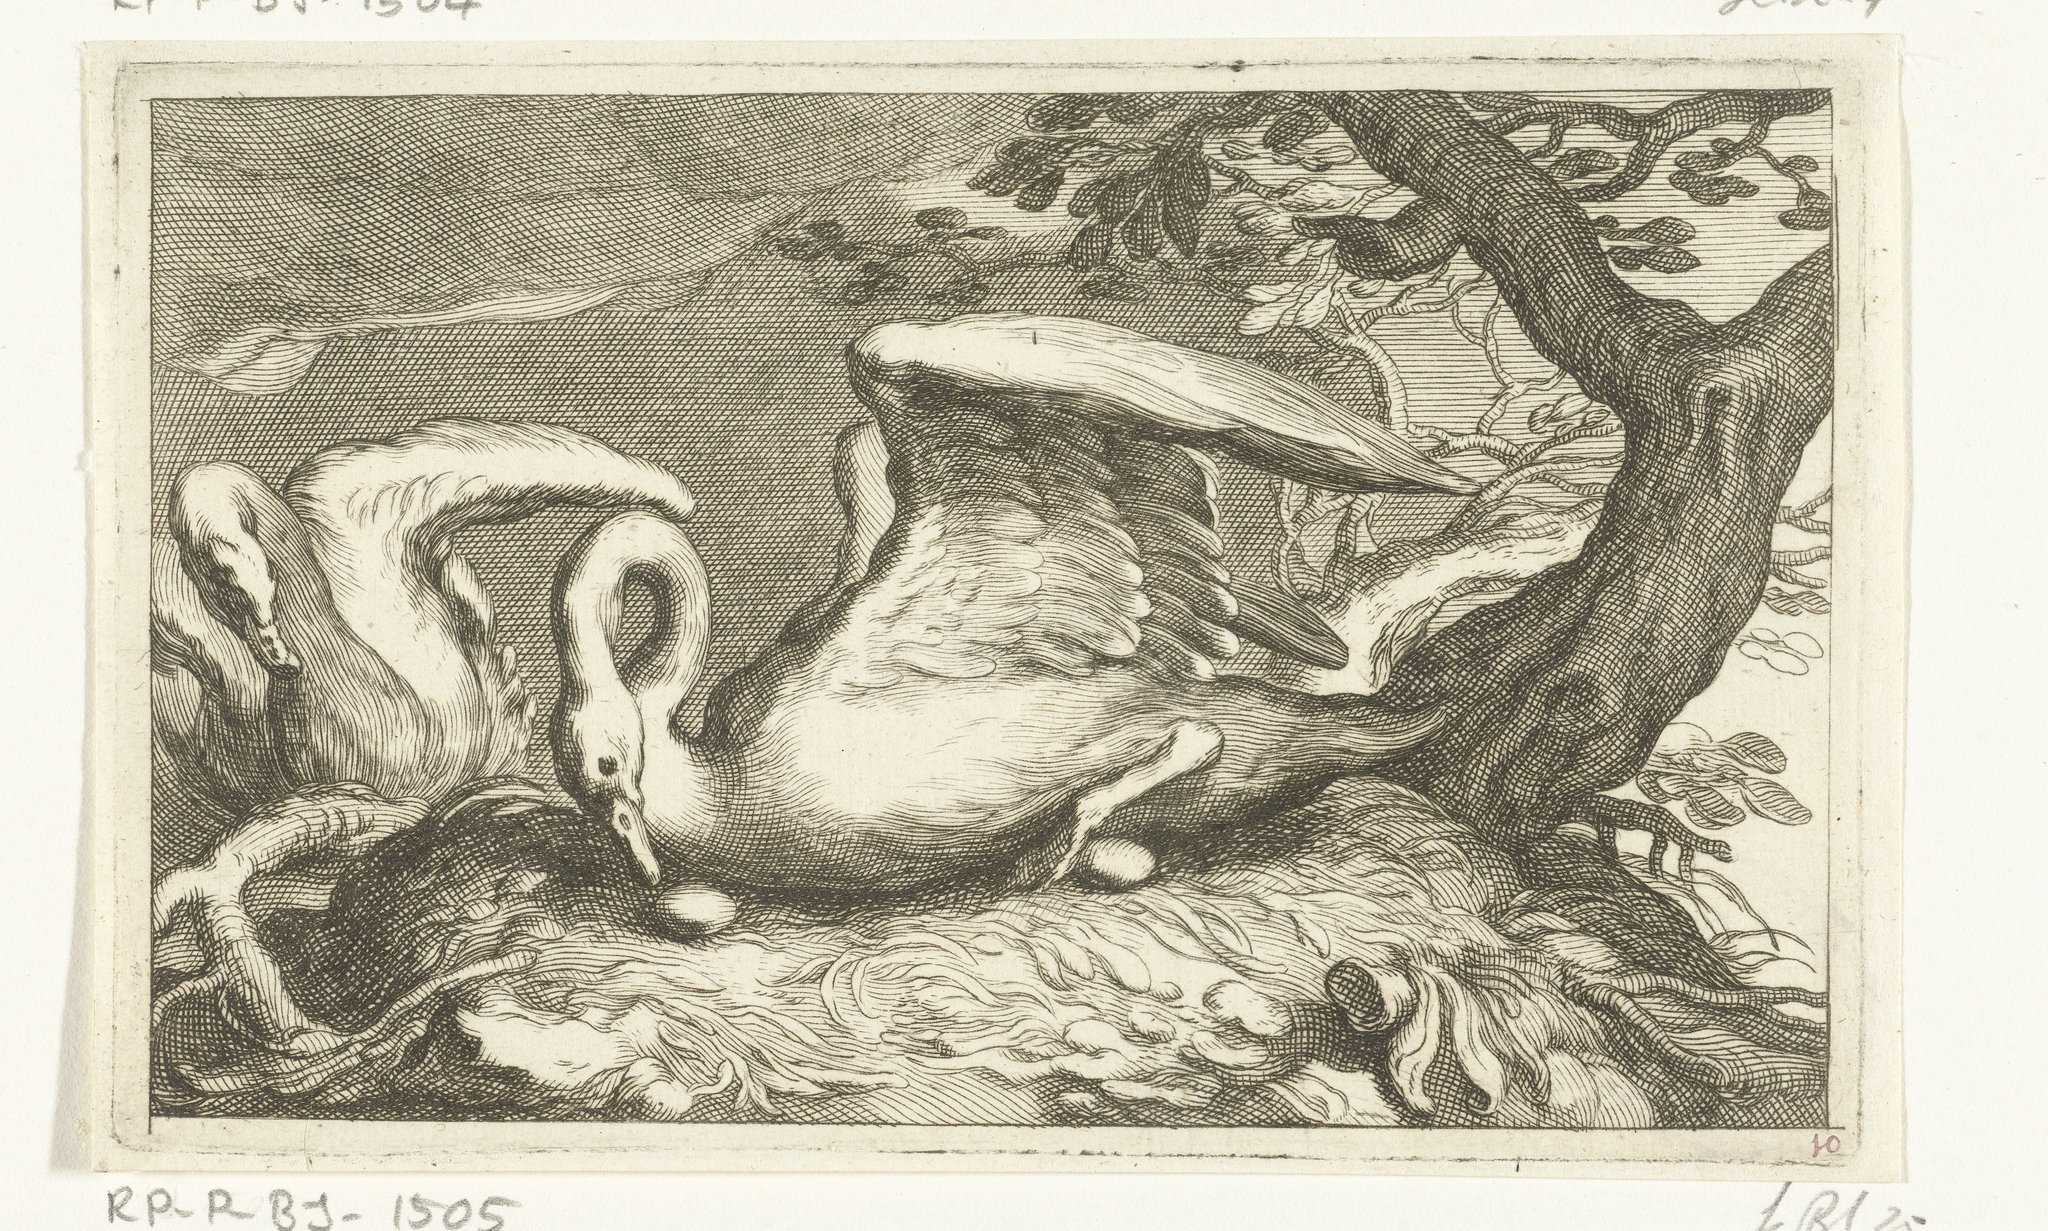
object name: print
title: Twee zwanen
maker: frederick bloemaert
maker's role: print maker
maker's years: 1614-1669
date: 1635-1670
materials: paper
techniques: engraving, etching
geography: utrecht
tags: water-birds: swan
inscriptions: number: ‘10’, collector's mark: Lugt 240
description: Twee zwanen in hun nest. De ene zit op twee eieren te broeden. Prent uit een serie van 14 prenten met verschillende inheemse dieren.